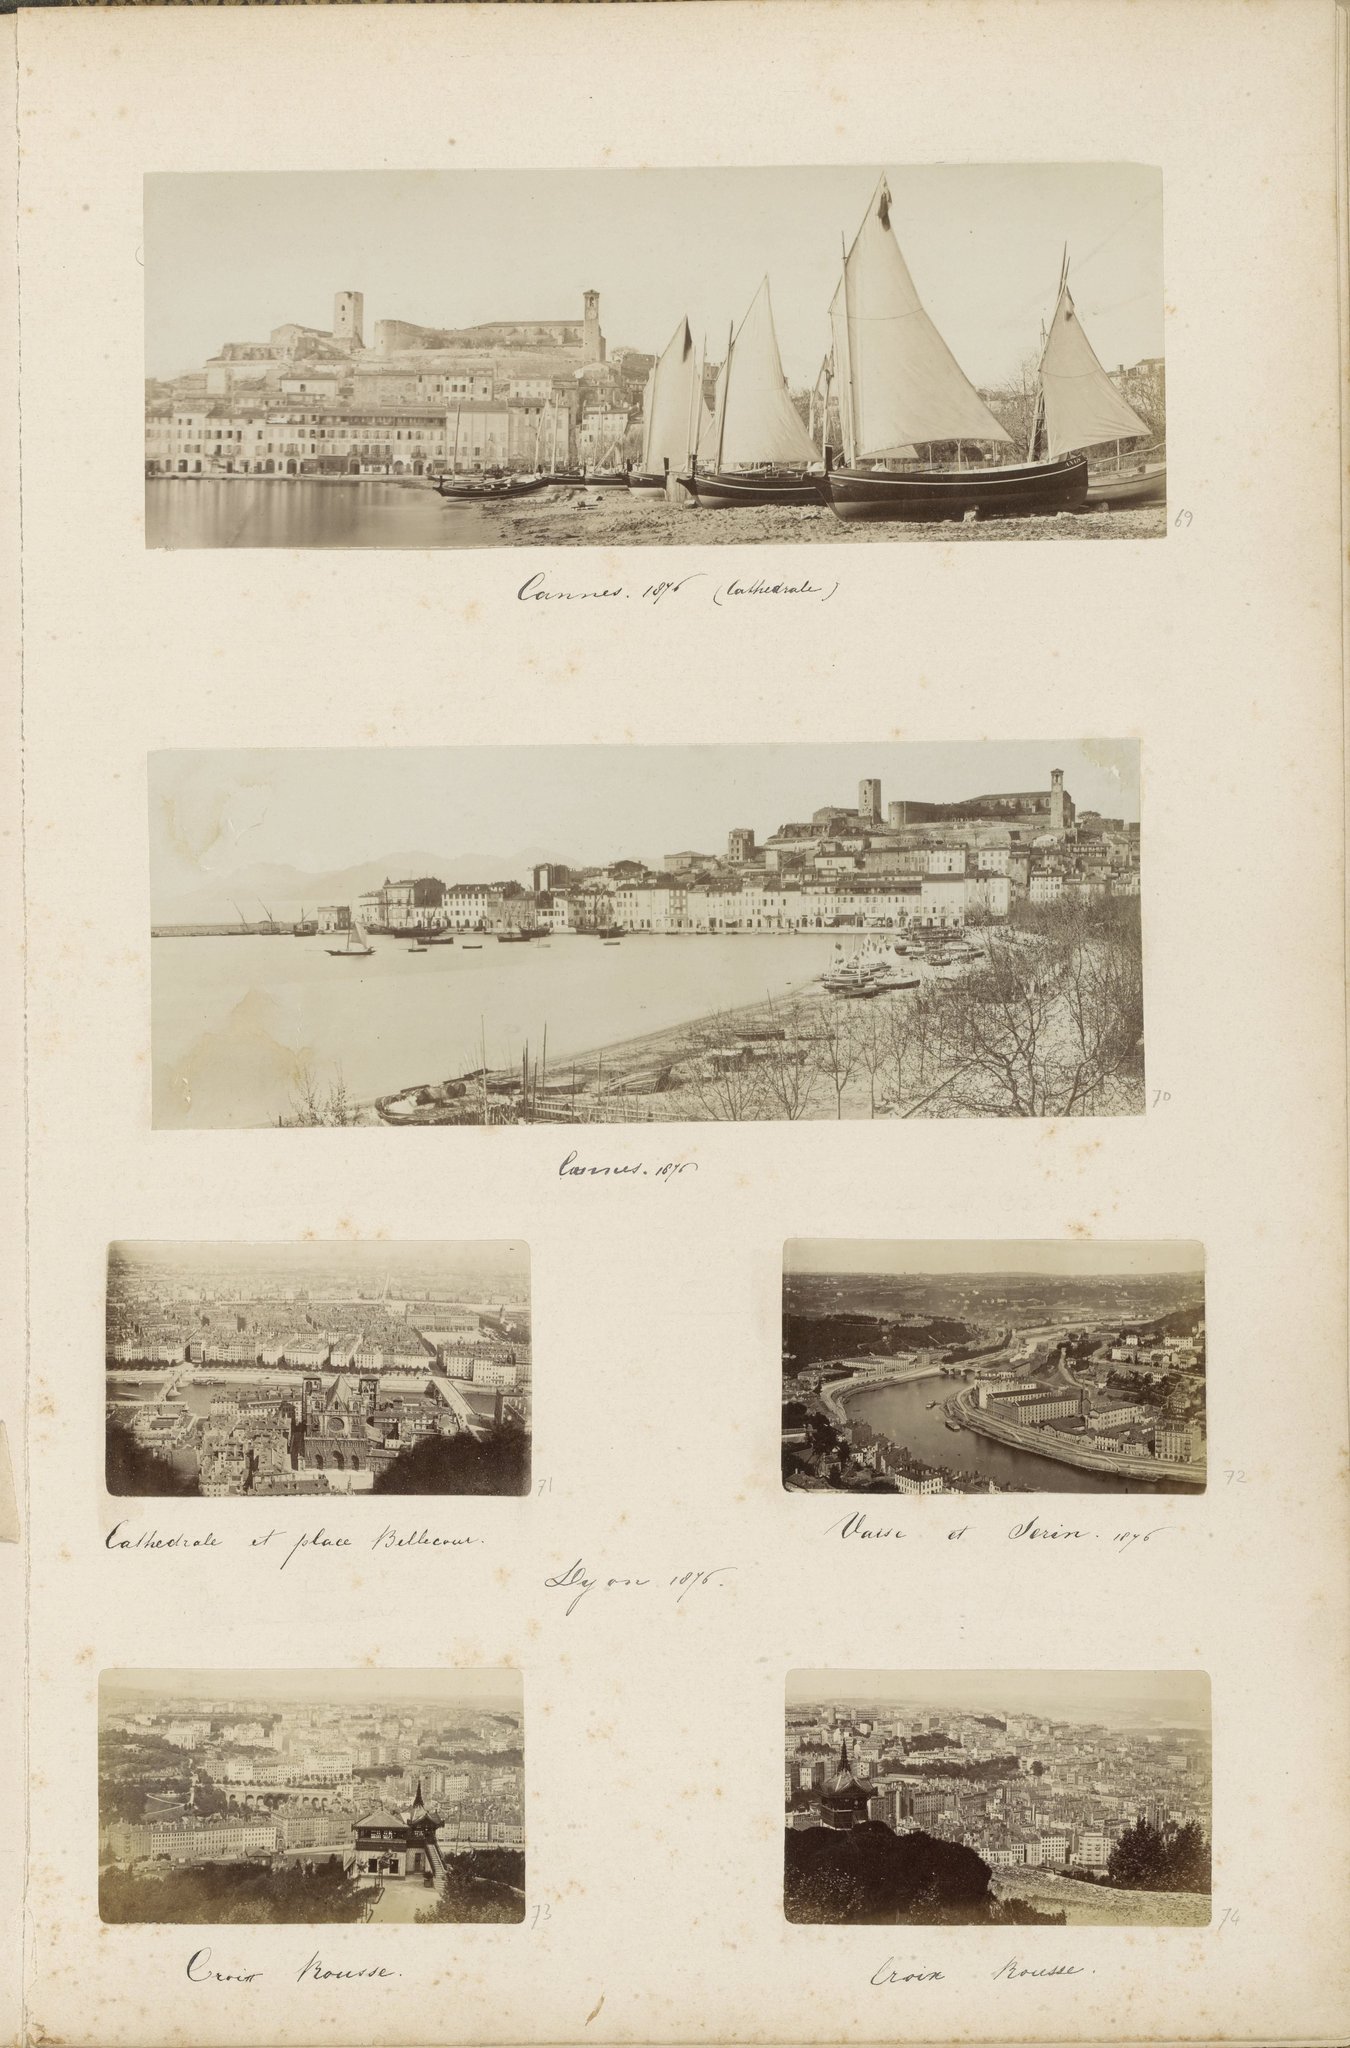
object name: album leaf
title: Gezicht op Vaise en Serin te Lyon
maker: Anonymous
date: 1876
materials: paper, photographic support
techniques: albumen print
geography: lyon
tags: river, prospect of city, town panorama, silhouette of city, lyon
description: Onderdeel van Fotoalbum van Robert Daniel Crommelin (1841-1907).